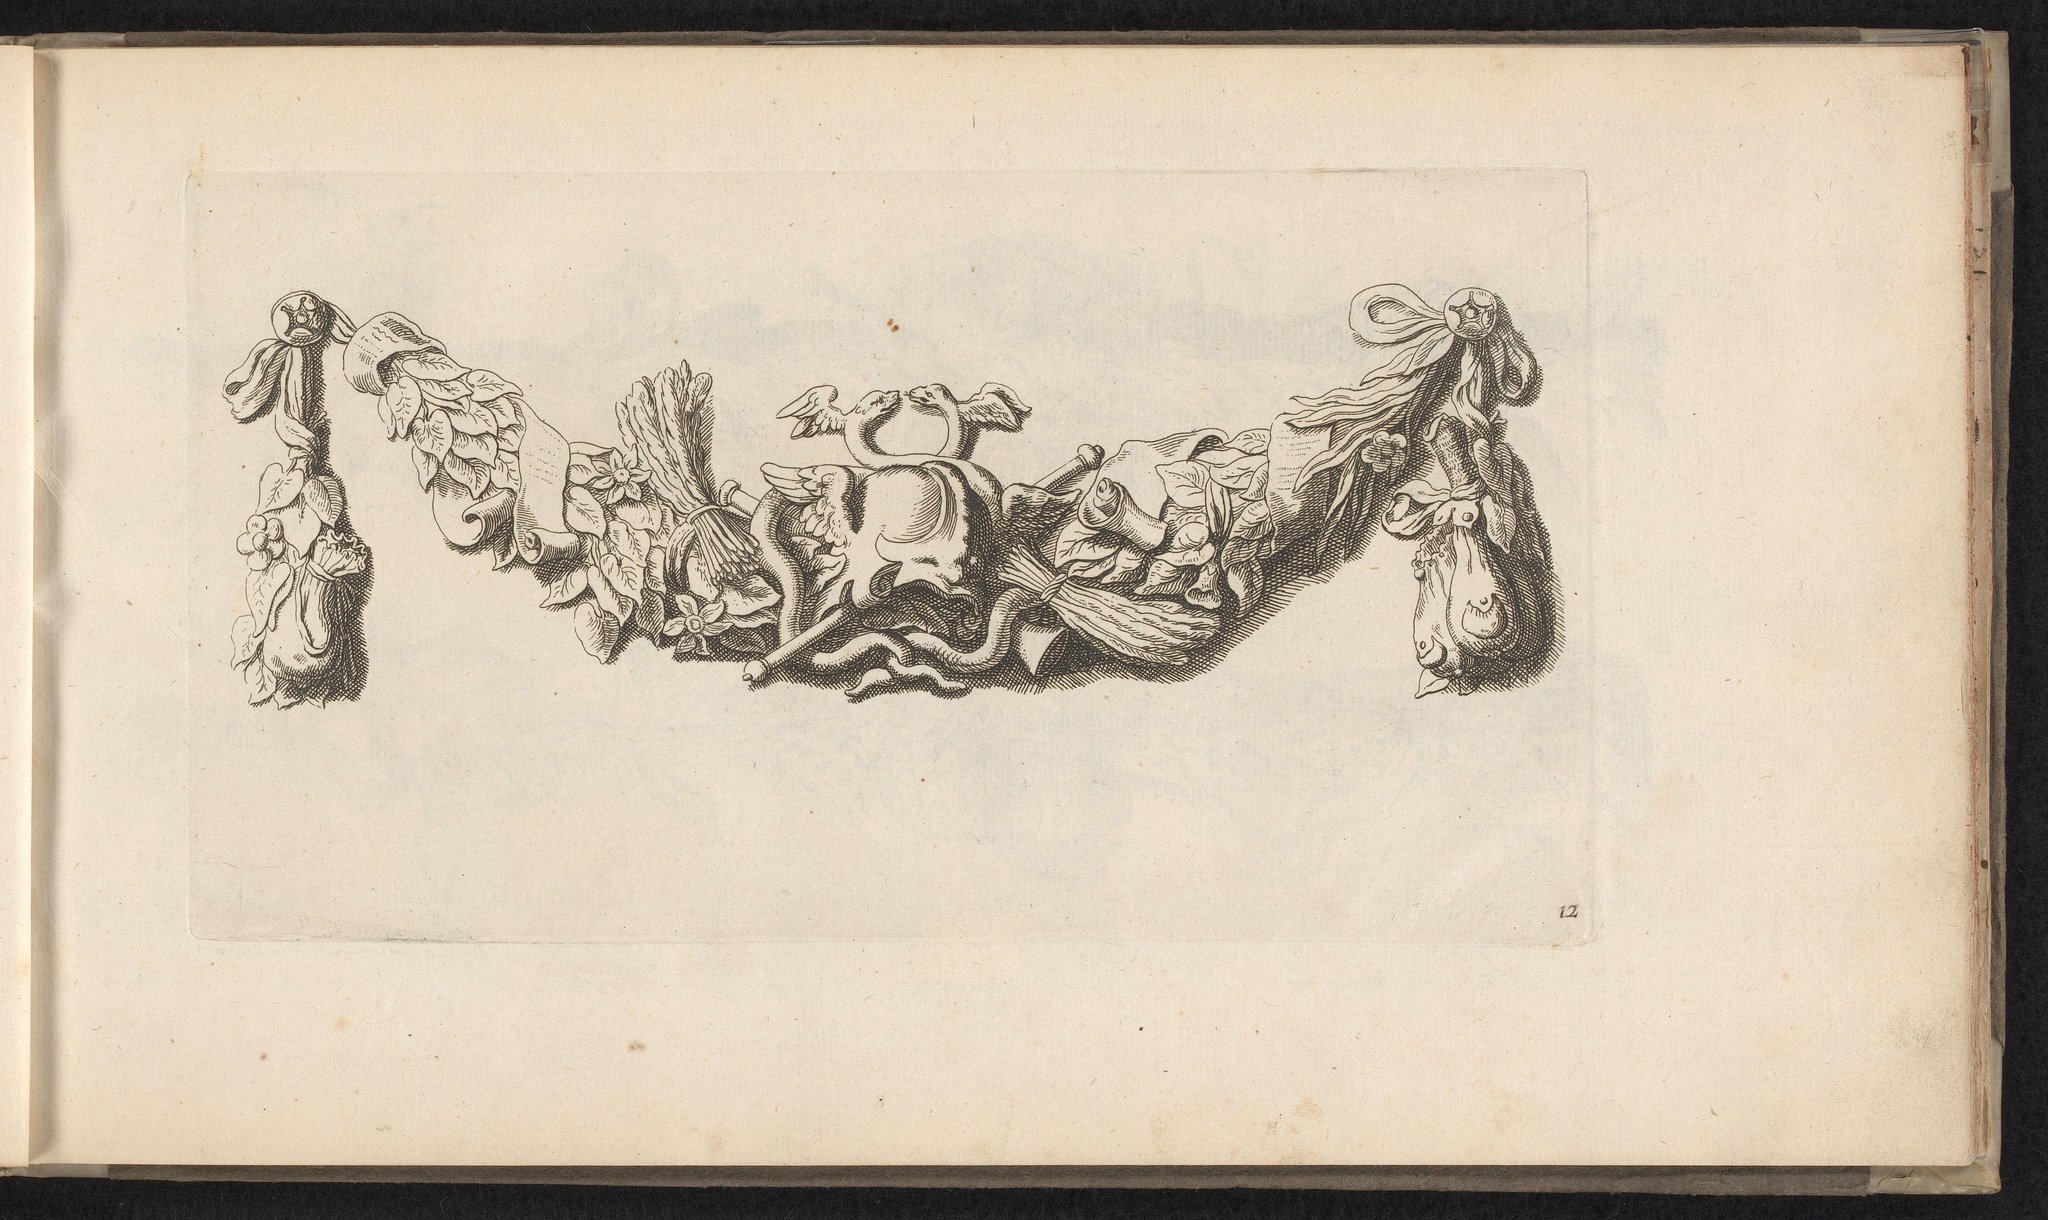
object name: ornament print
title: Festoen met geldbuidels uit het stadhuis van Amsterdam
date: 1665-1685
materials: ink, paper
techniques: etching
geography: amsterdam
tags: purse, money-bag, attributes of mercury, ornament ~ festoon, garland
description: Prent uit elf genummerde prenten met festoenen. Kopieën in dezelfde richting naar de prenten in Artus Quellinus, Prima Pars Praecipuarium (…), Amsterdam 1665. Gebonden in 19de-eeuwse band met blauwe kaft en witte rug, genummerd: 3.